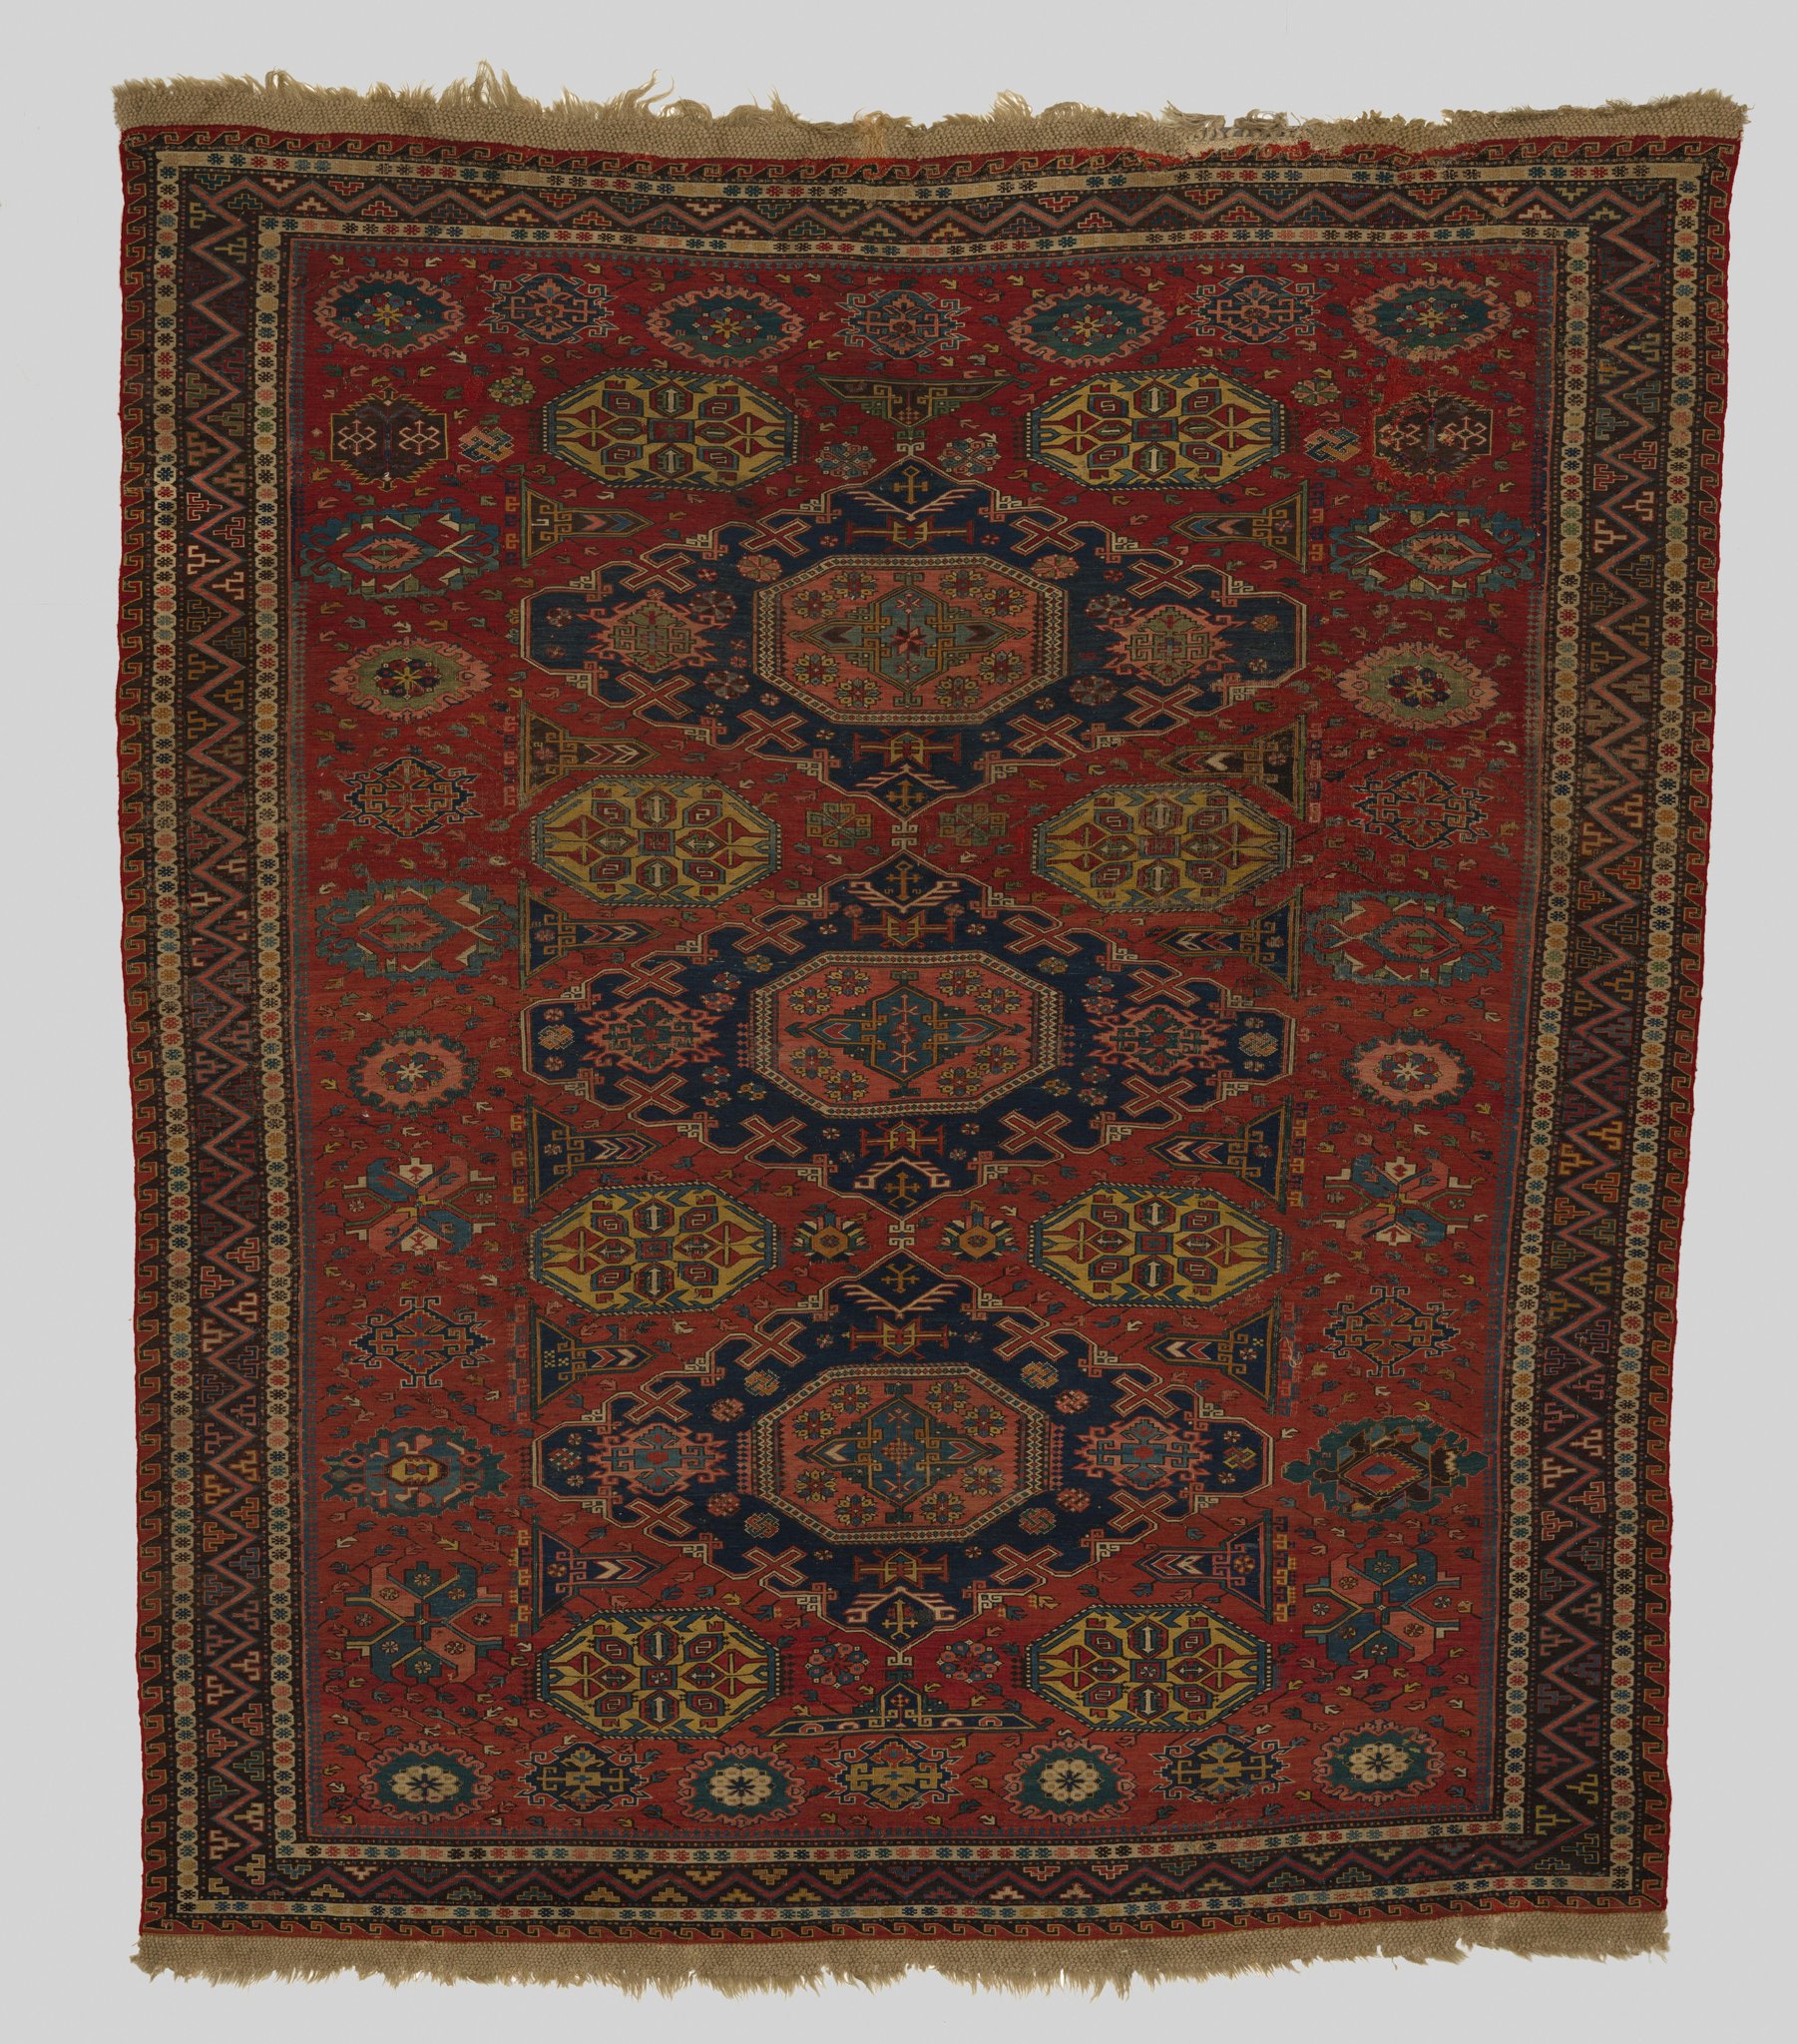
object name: oriental rug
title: Oosters tapijt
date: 1850-1900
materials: wool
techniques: soumak, weave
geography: caucasus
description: Oosters tapijt, medaillonkleed, in soumak-techniek. Op het middenveld staan drie ruiten en achthoeken met bloemtak tegen een steenrood fond; hieromheen rozetten. Veelvoudige randen, breedste met zigzag-lijn.